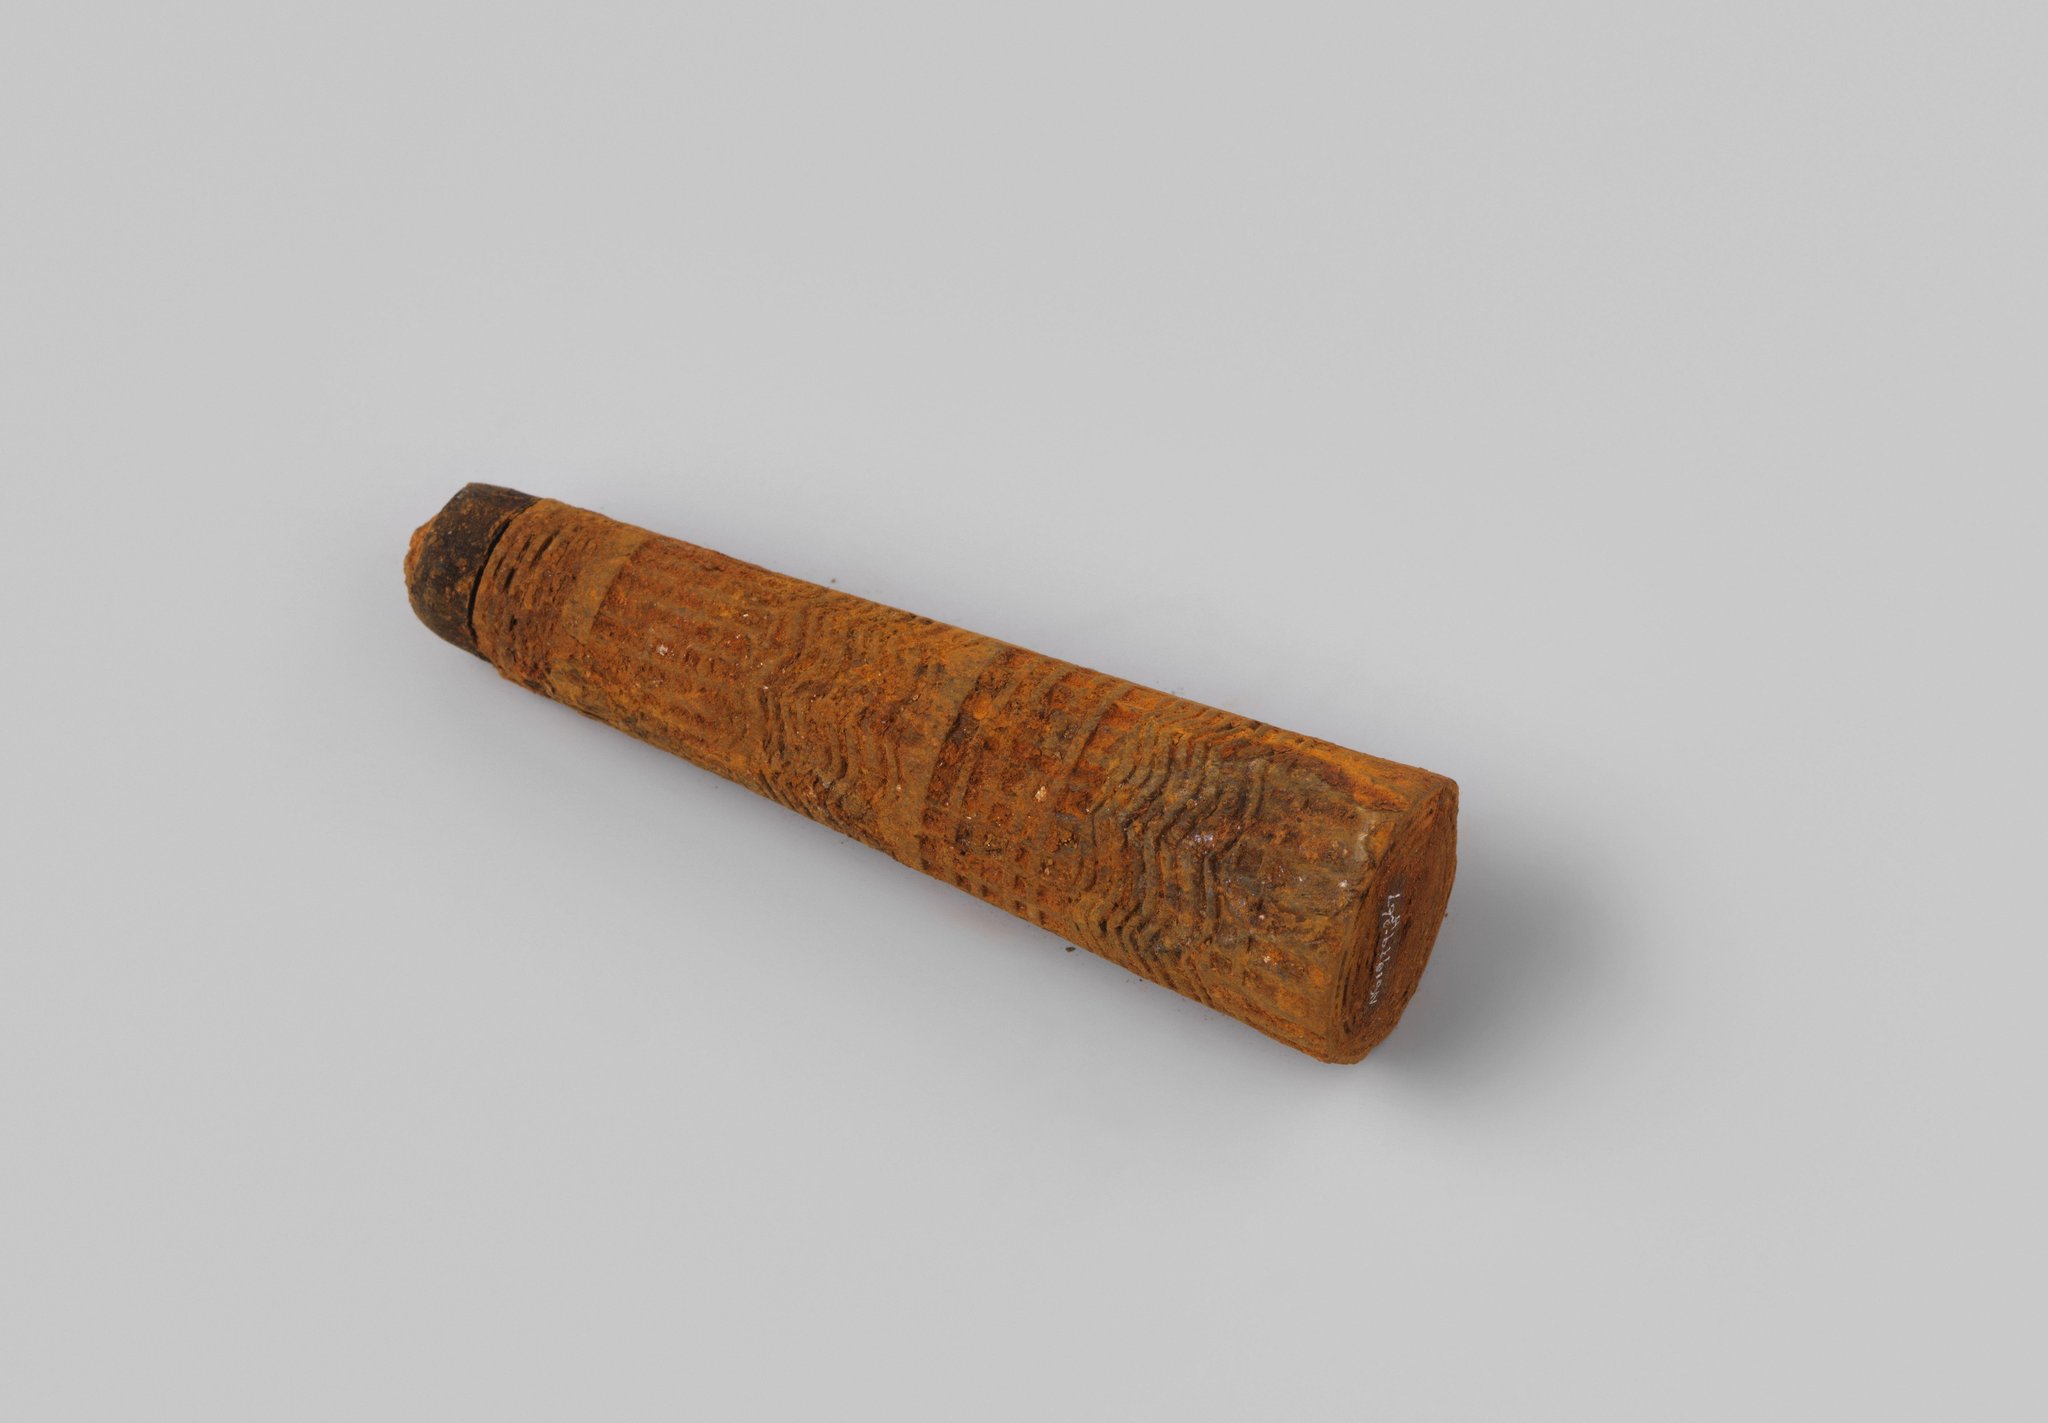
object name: knife handle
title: Messenheft uit het wrak van de Oost-Indiëvaarder Hollandia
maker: Anonymous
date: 1700-1743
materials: wood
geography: netherlands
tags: verenigde oostindische compagnie, hollandia (schip), annet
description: Knife, handle, cylindrical: tapering; id. NG 1979-403H, ferrules id. NG 1980-27H426.